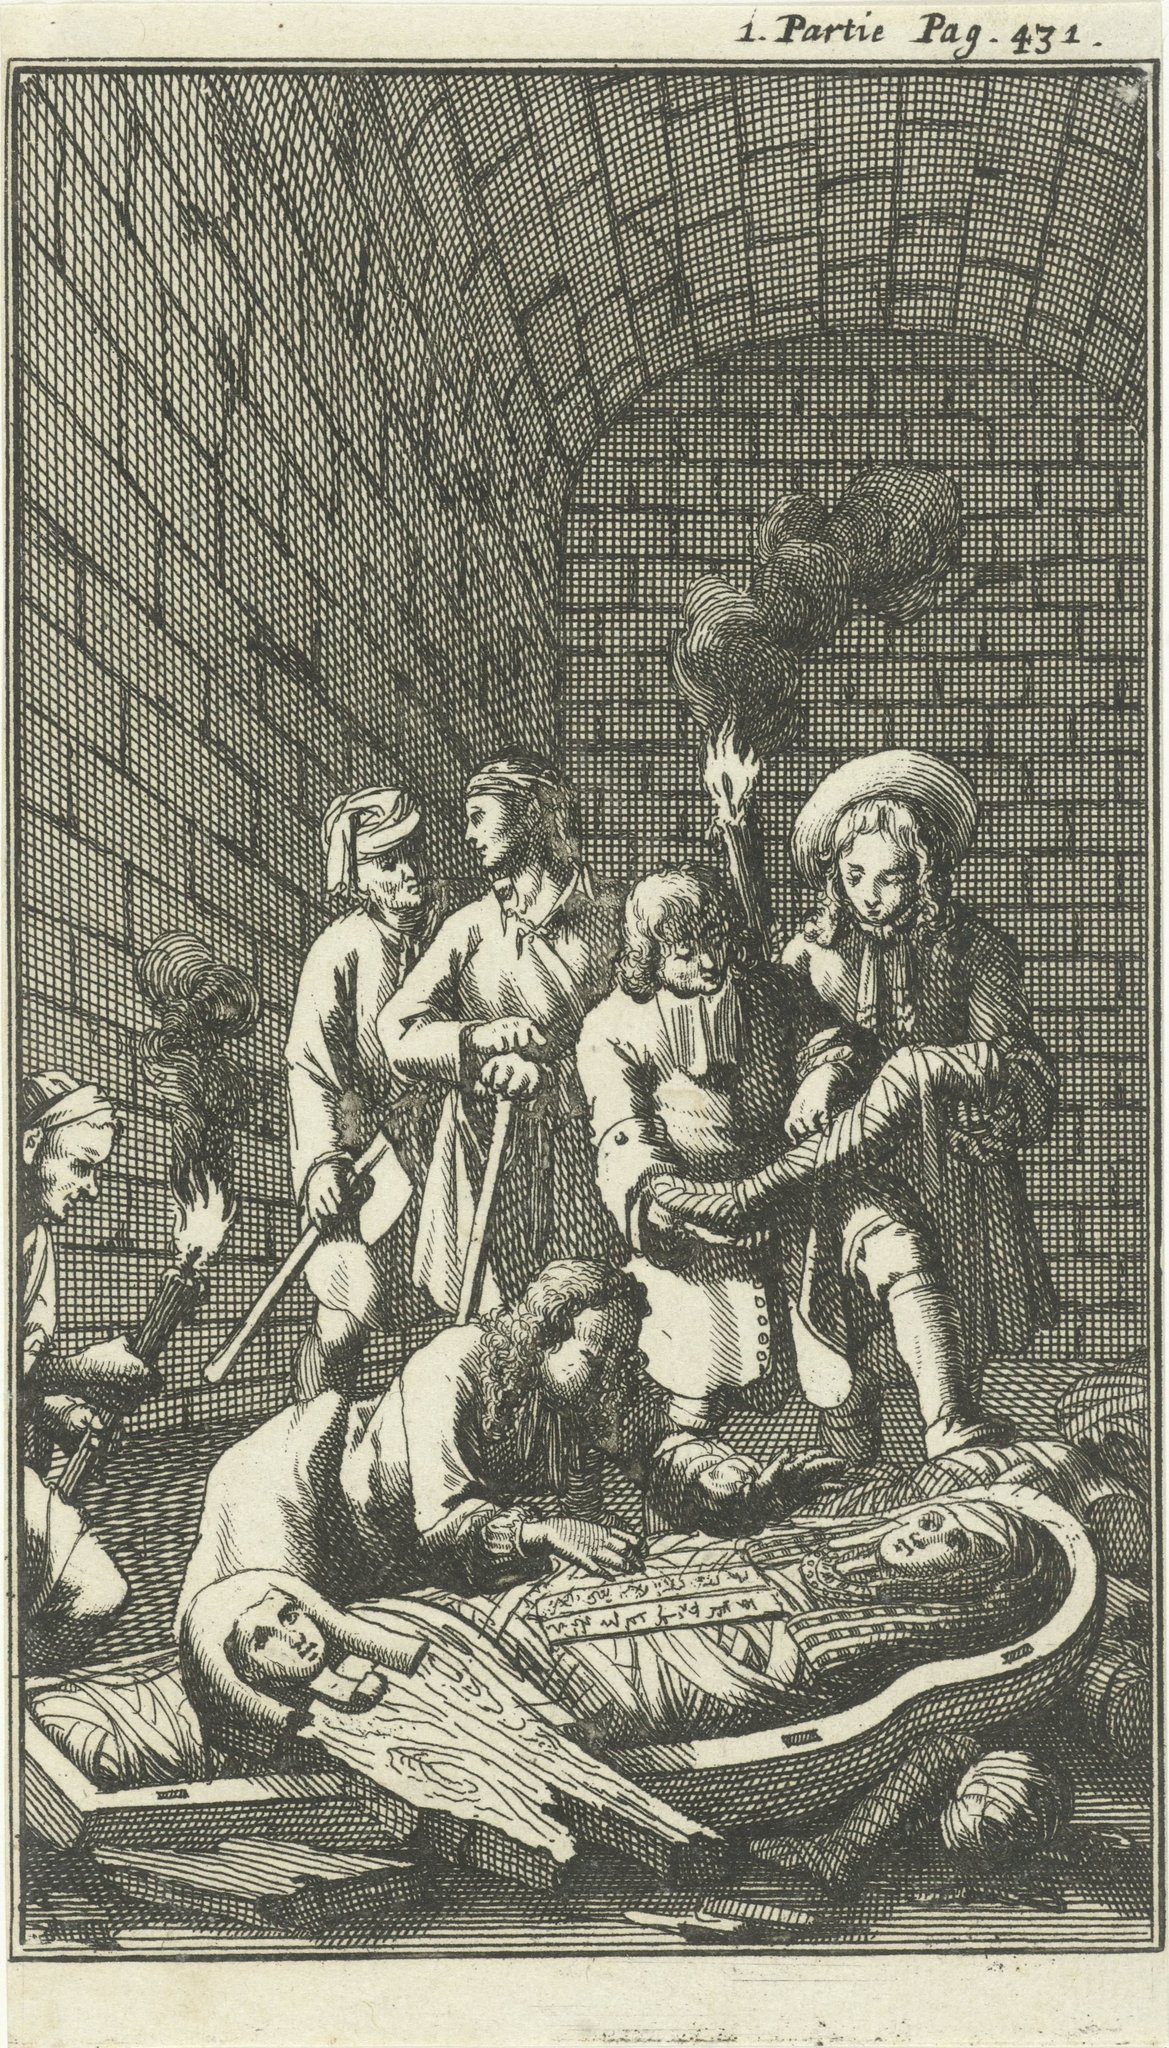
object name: print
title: Figuren vinden een mummie in een piramide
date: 1689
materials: paper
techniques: etching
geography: amsterdam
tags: pyramid (marking grave), mummy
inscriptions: collector's mark: Lugt 2228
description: Illustratie uit: Thevenot, Jean de. Voyages Tant en Europe qu'en Asie et en Afrique, 4 delen. Parijs: Charles Angot, 1689, dl. II.